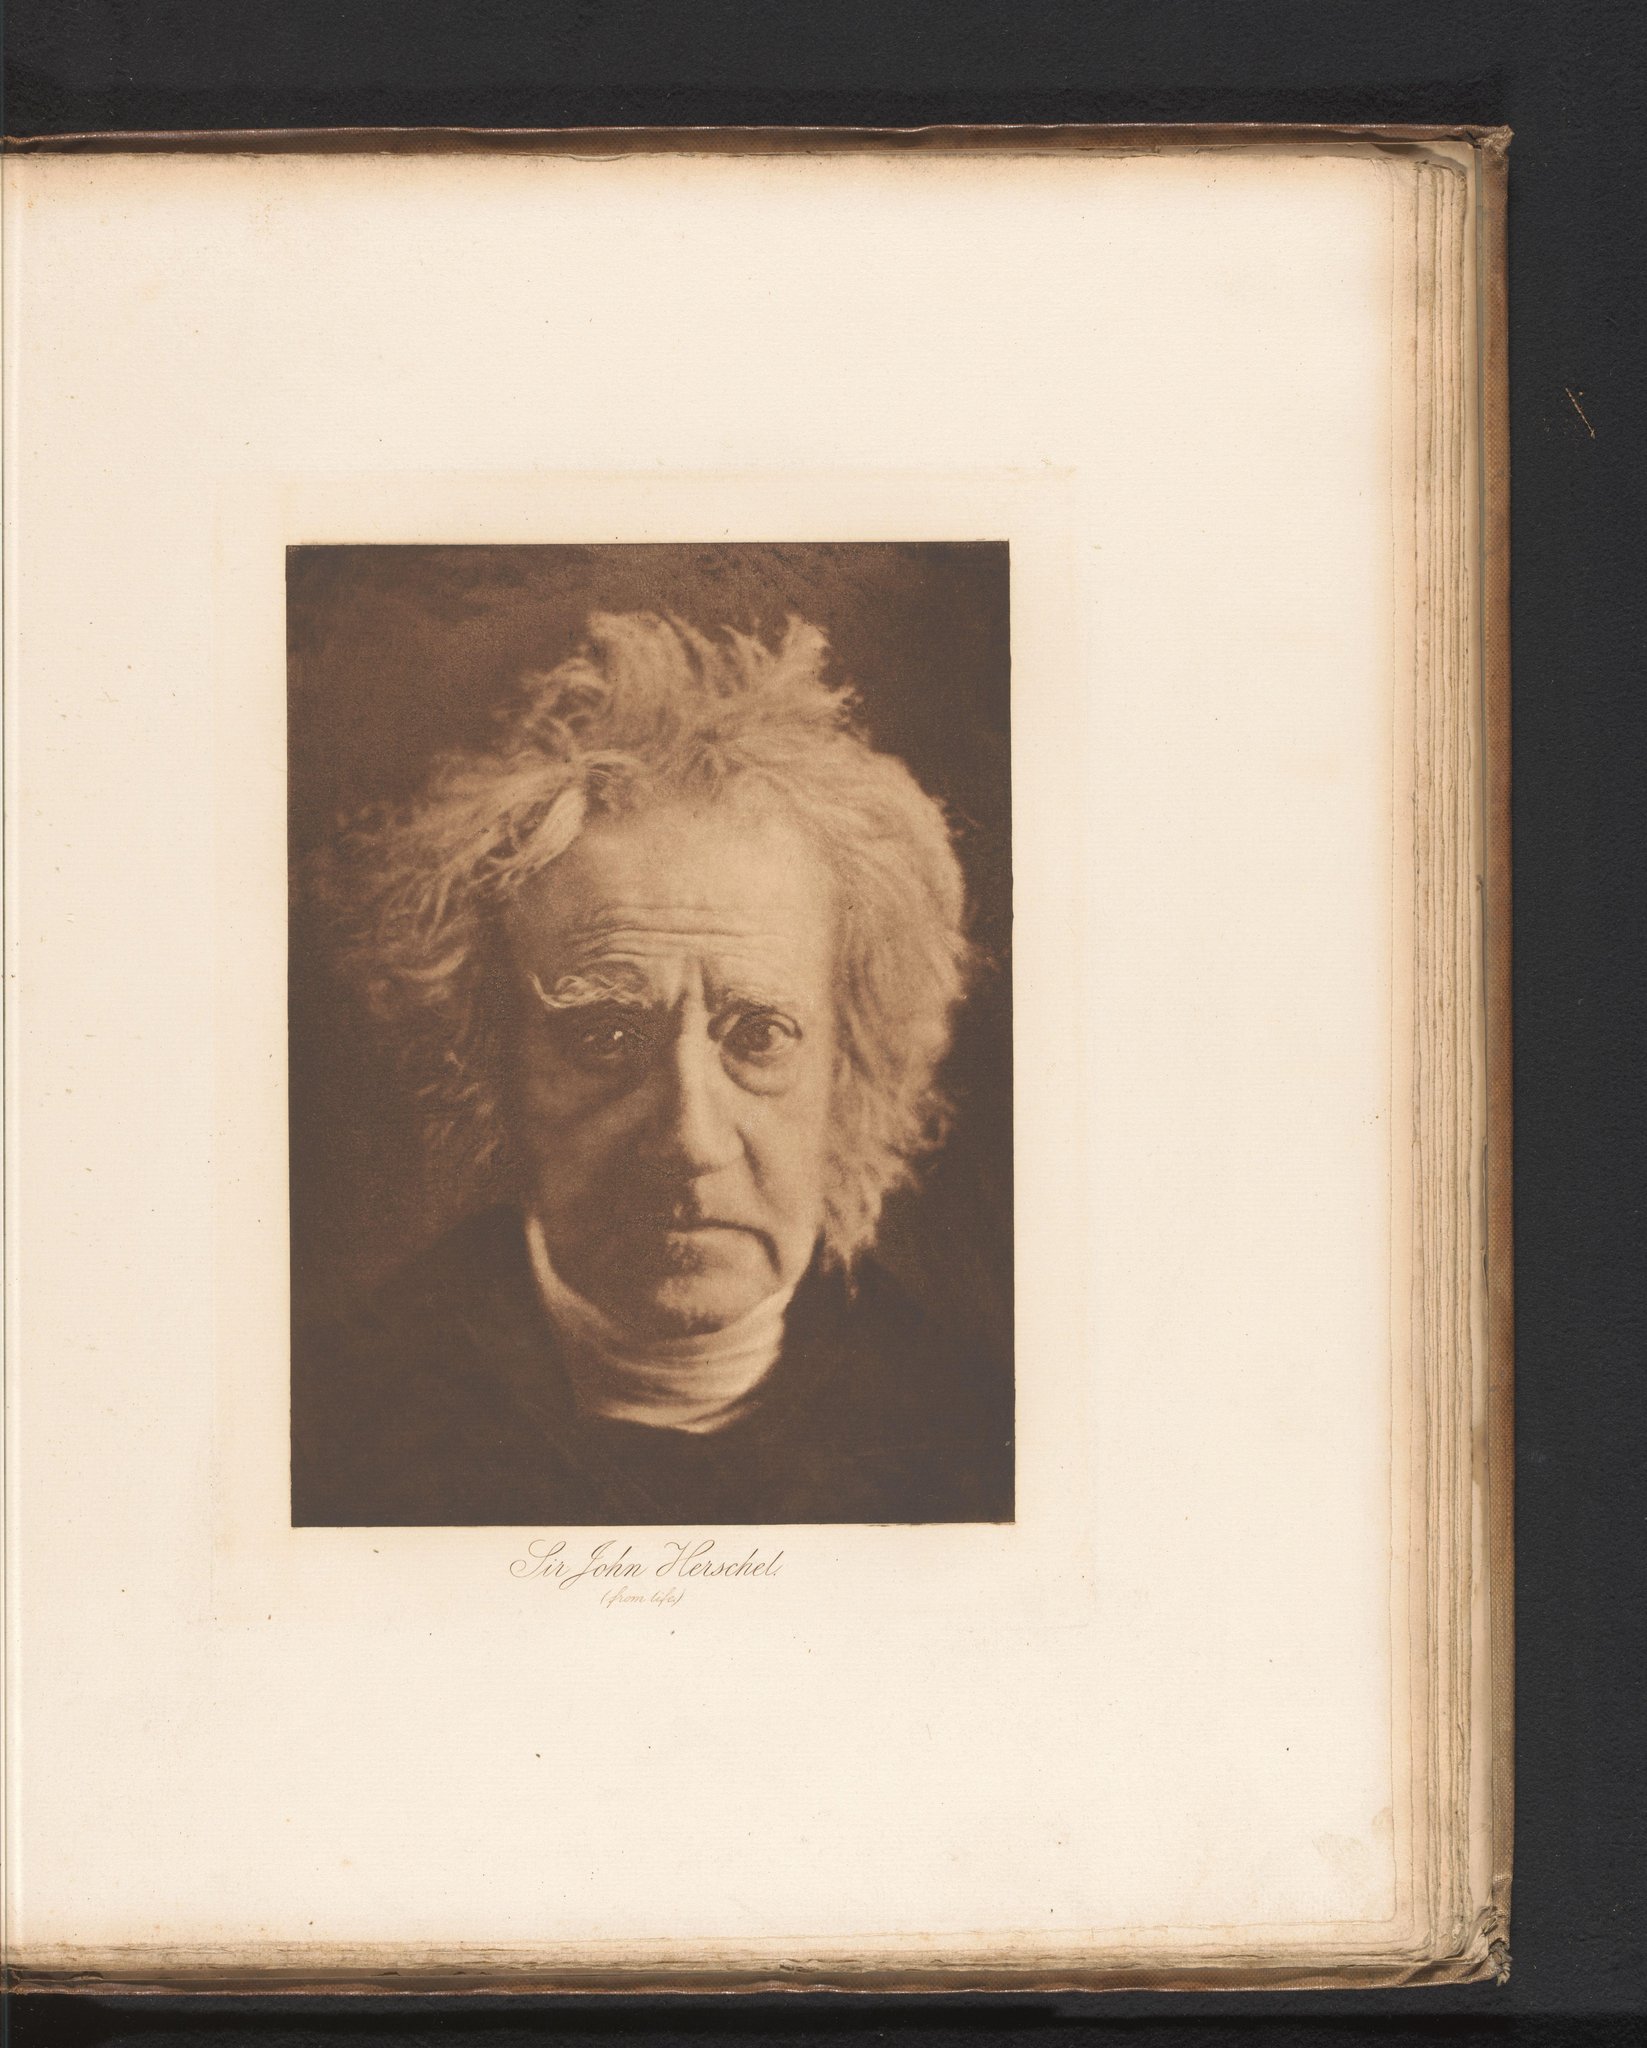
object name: photomechanical print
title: Sir John Herschel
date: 1867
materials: paper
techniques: photoaquatint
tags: astronomy (and cosmography) (+ portrait of scholar, scientist), historical persons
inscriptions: inscription: ‘Sir John Herschel/ (from life.)’